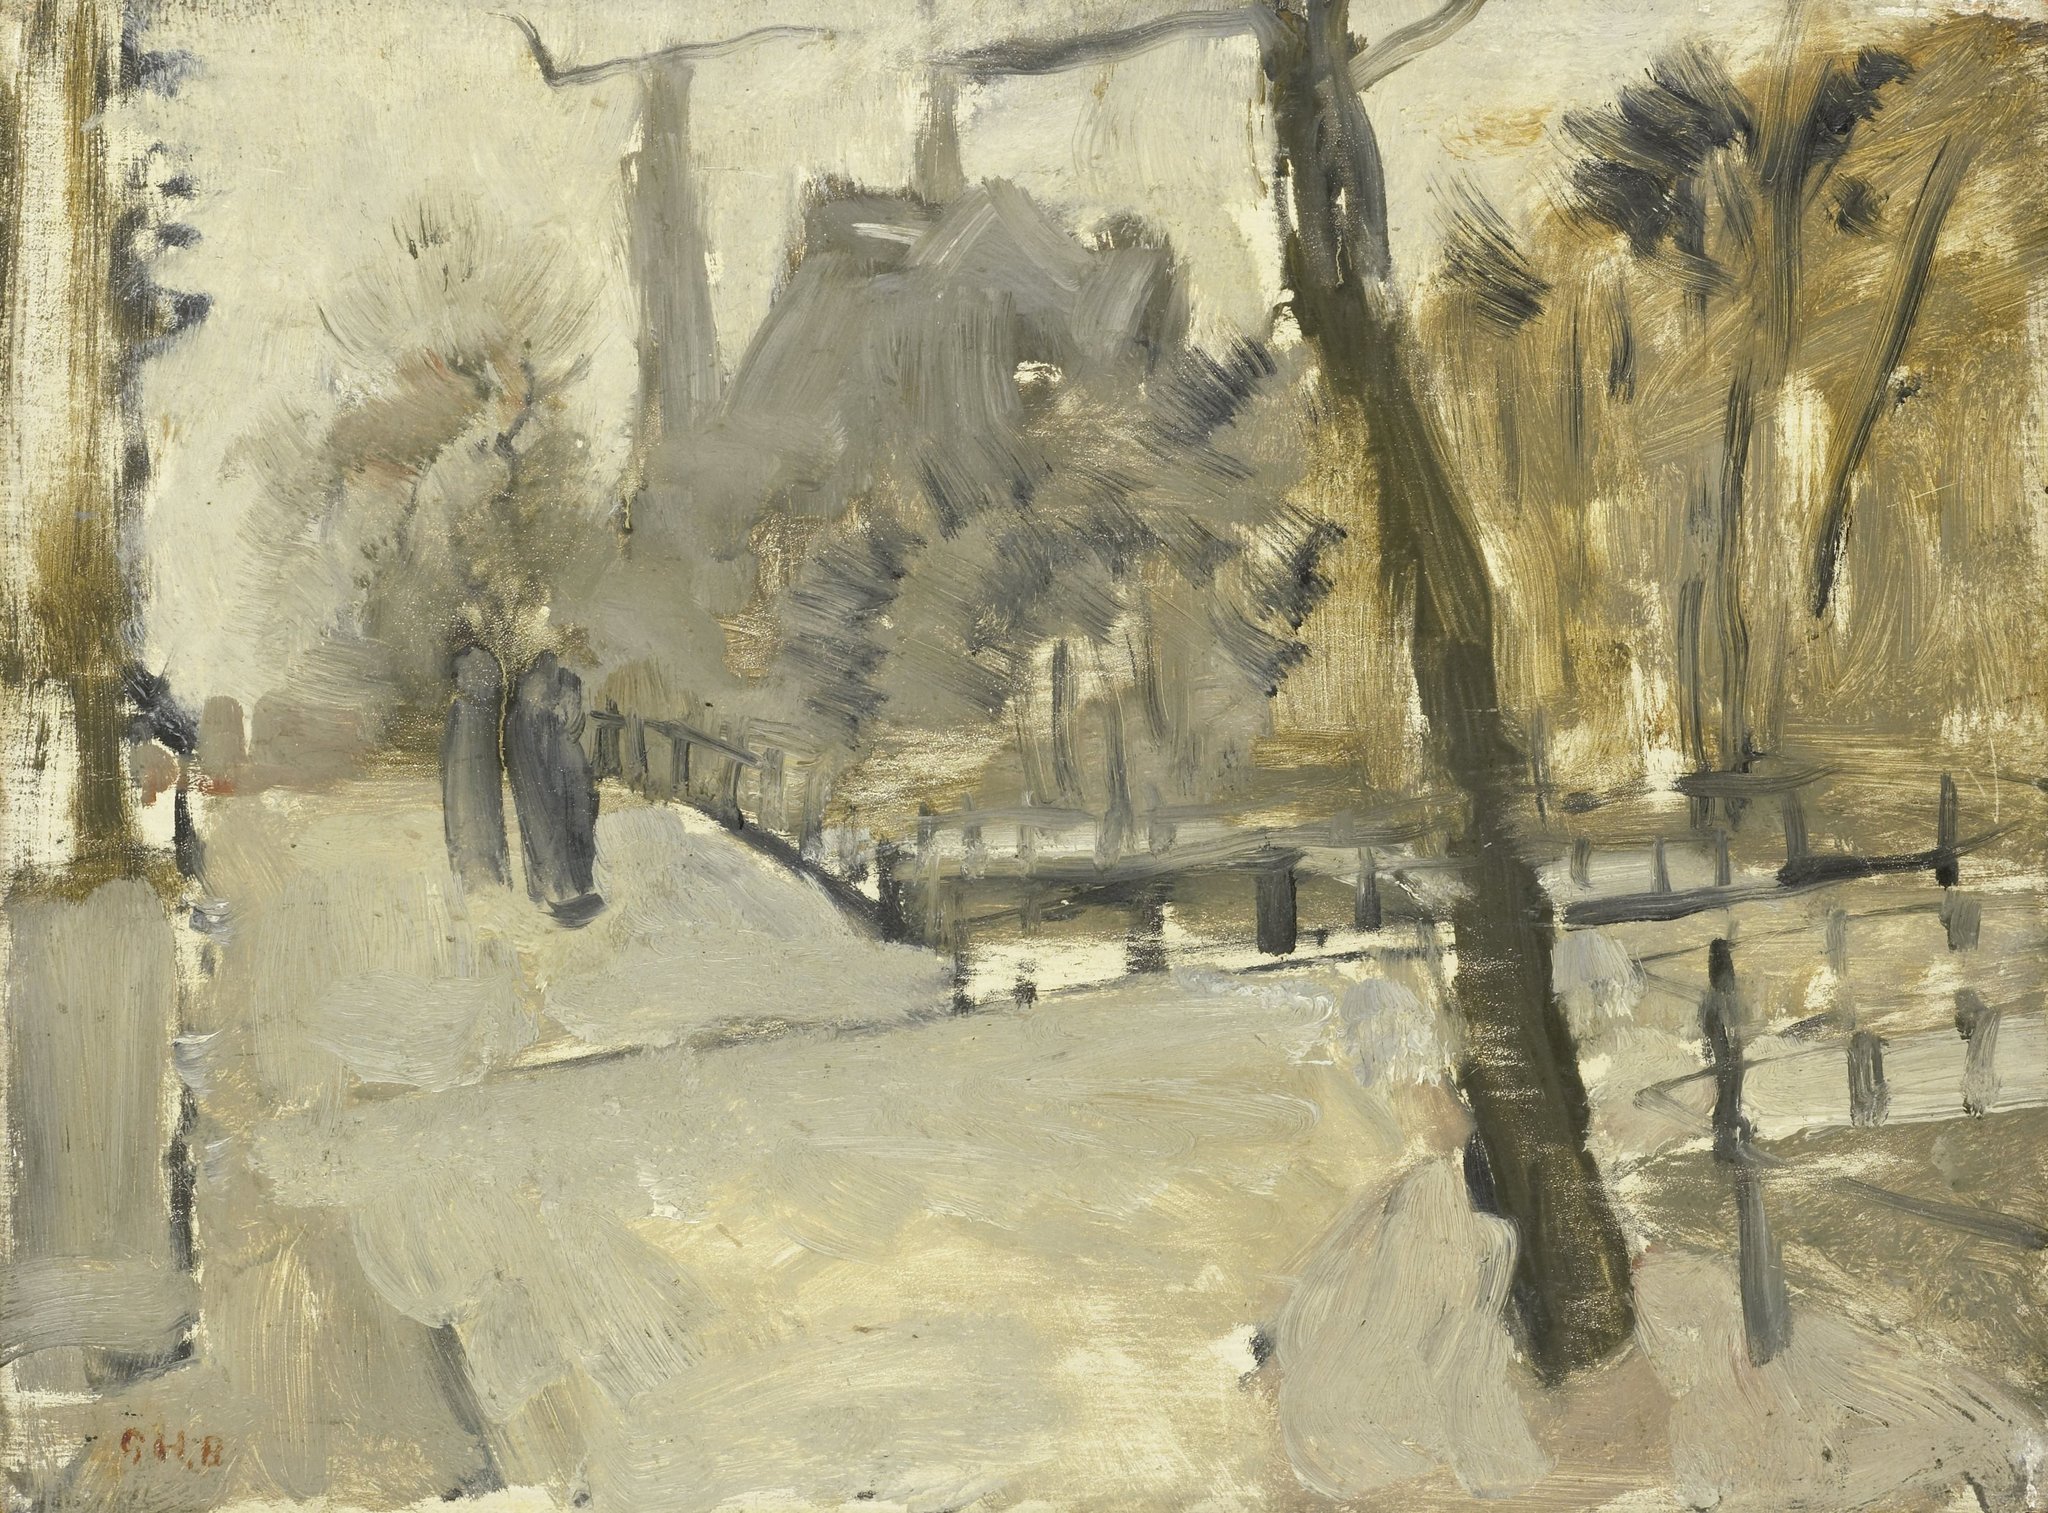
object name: painting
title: The Leidsegracht, Amsterdam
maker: george hendrik breitner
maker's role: draughtsman, painter, print maker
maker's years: 1857-1923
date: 1880-1923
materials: oil, panel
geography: amsterdam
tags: canals, waters (in city)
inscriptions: signature: ‘G.H.B.’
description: Gezicht op de Leidsegracht te Amsterdam. Over een brug gaan twee vrouwen, op de voorgrond een boom.